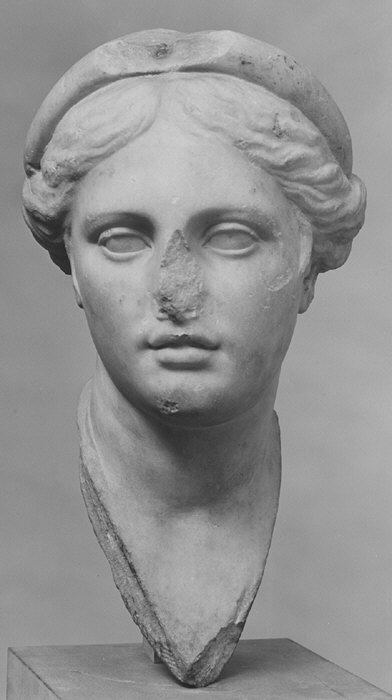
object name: head of a woman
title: Marble head of a woman, perhaps a queen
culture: roman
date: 100-1 BCE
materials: marble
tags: heads,women